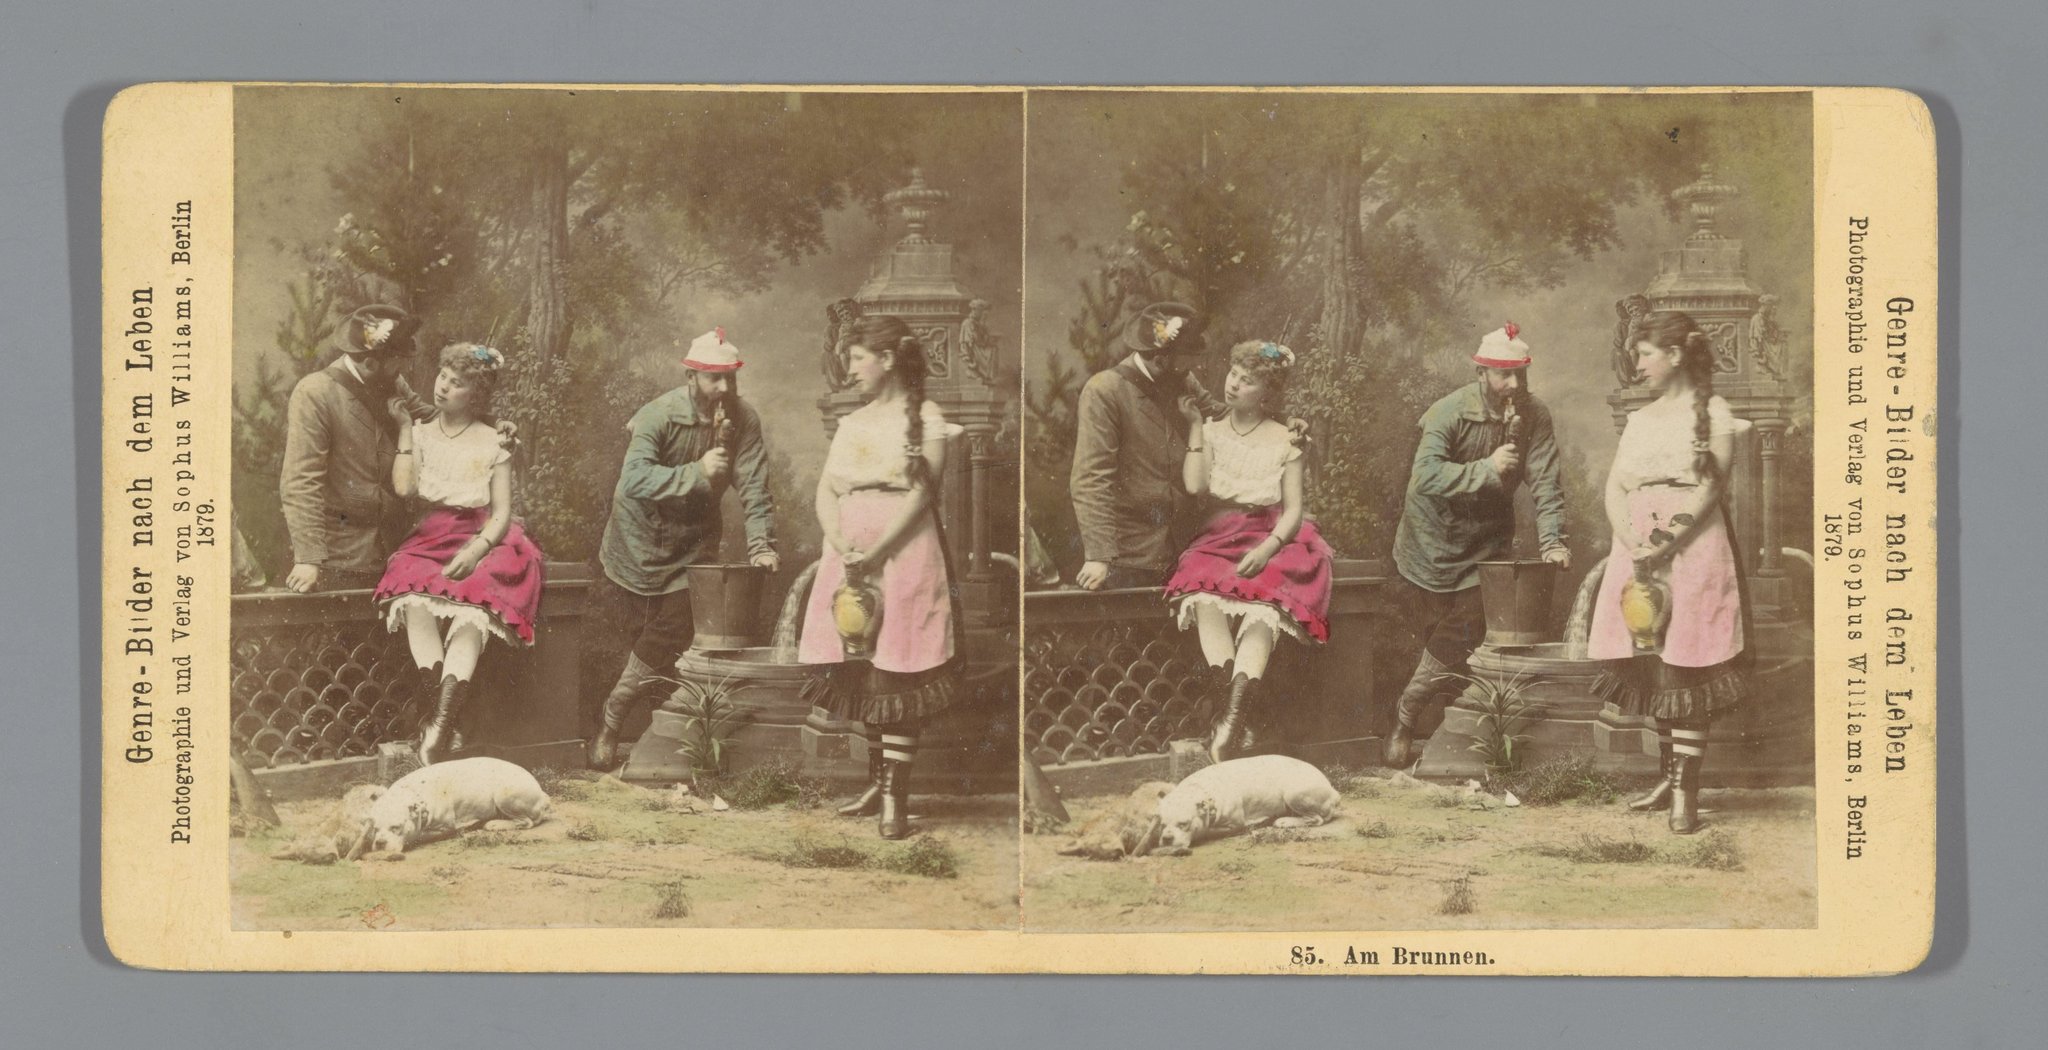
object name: stereograph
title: Groep mensen rond een fontein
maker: sophus williams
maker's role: publisher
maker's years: 1835-1900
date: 1879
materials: cardboard, paper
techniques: albumen print, hand coloring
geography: berlin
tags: ornamental fountain, anonymous historical persons portrayed in a group, in a group-portrait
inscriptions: number: ‘60’, number: ‘85’